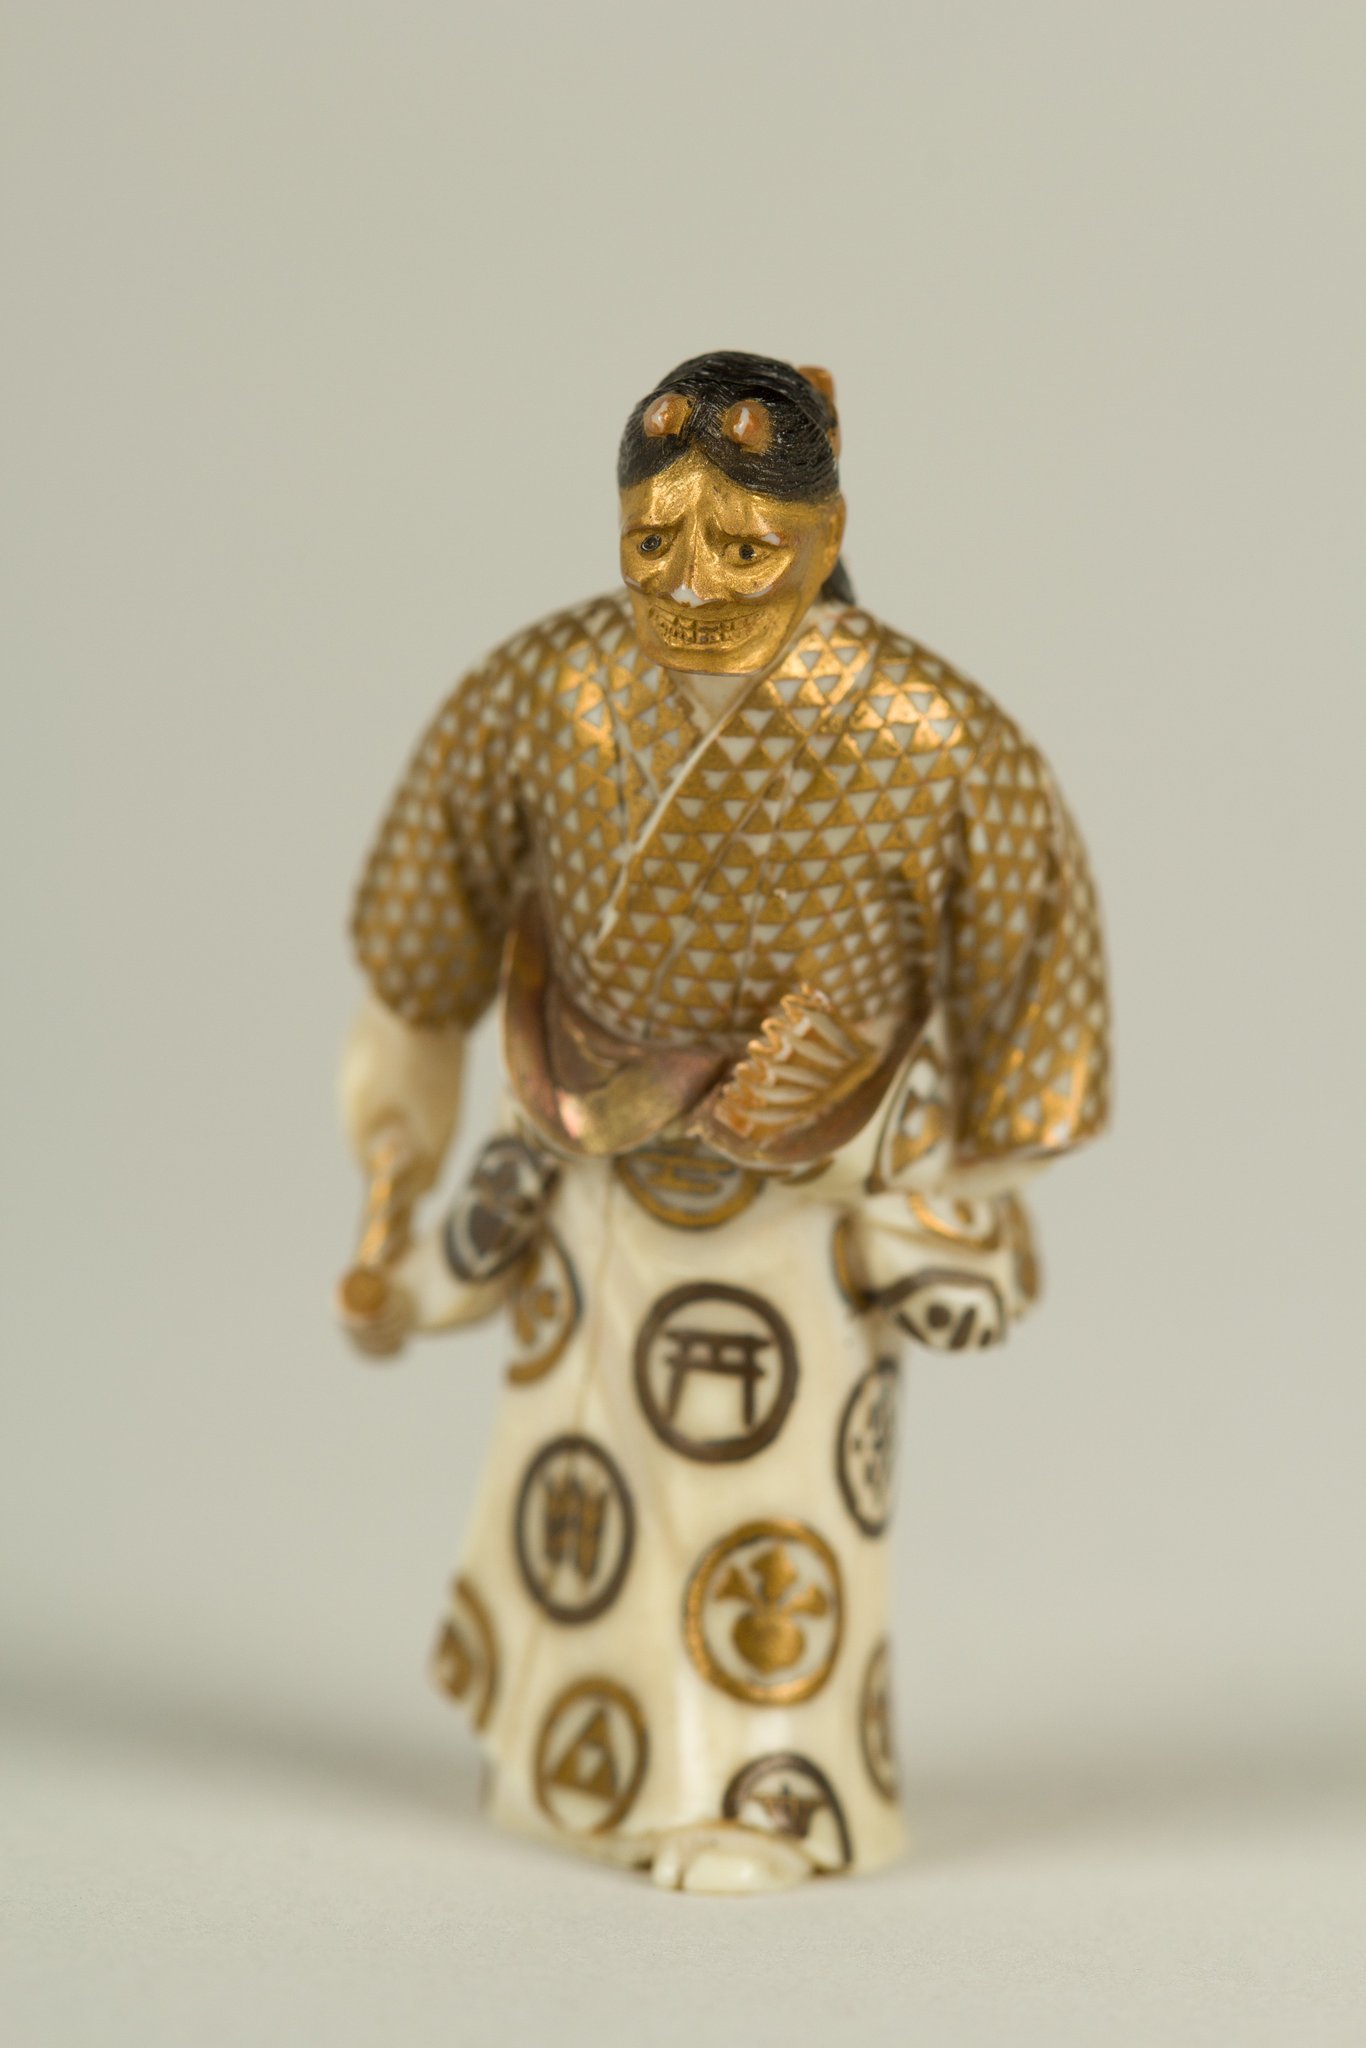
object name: netsuke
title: Netsuke of an Actor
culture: japanese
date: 1801-1900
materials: gold, ivory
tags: men,actors